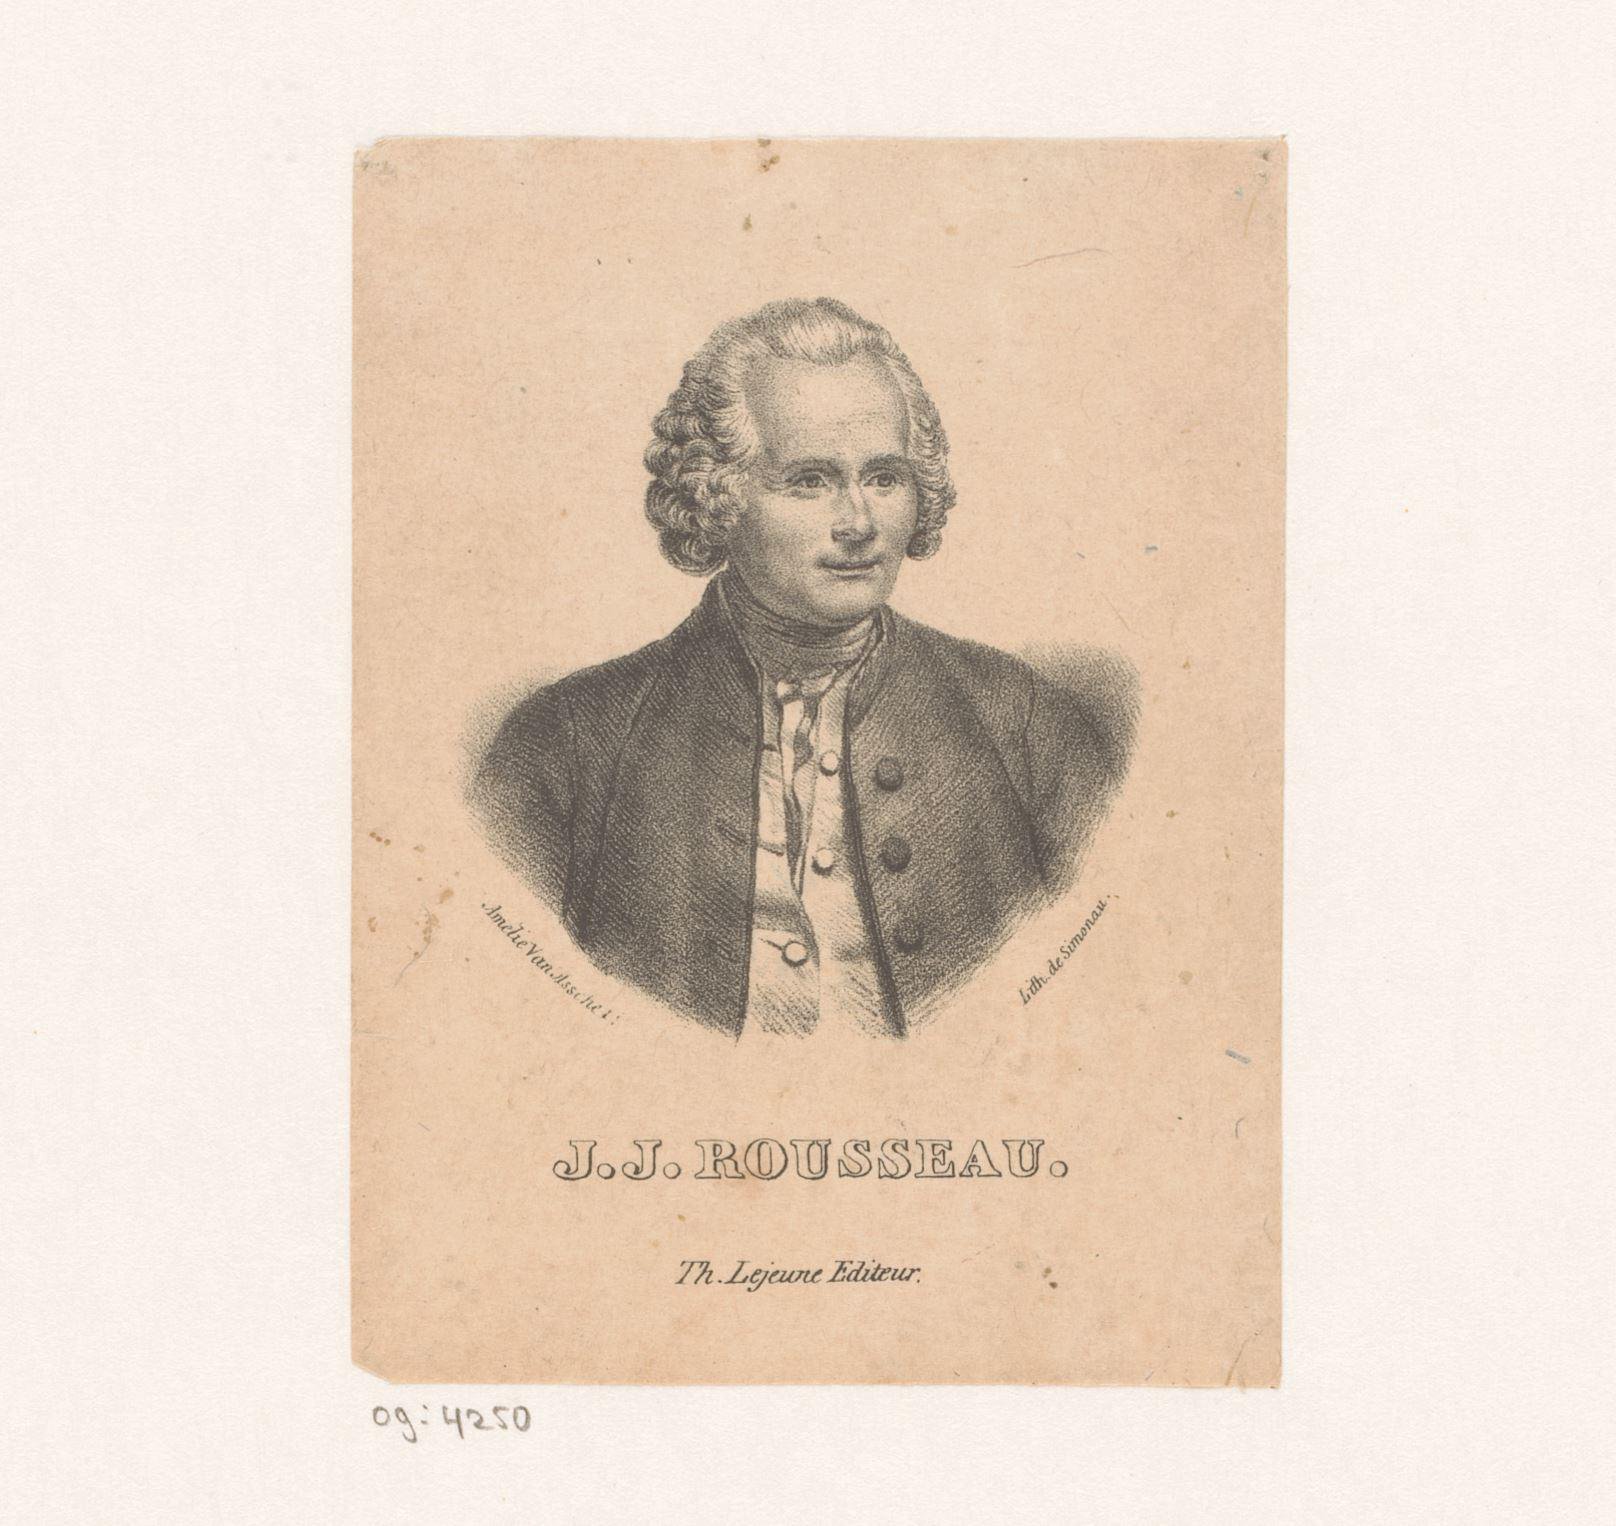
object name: print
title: J.J. Rousseau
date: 1828-1838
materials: paper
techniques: lithograph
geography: brussels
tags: adult man, historical persons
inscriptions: collector's mark: Lugt 2228